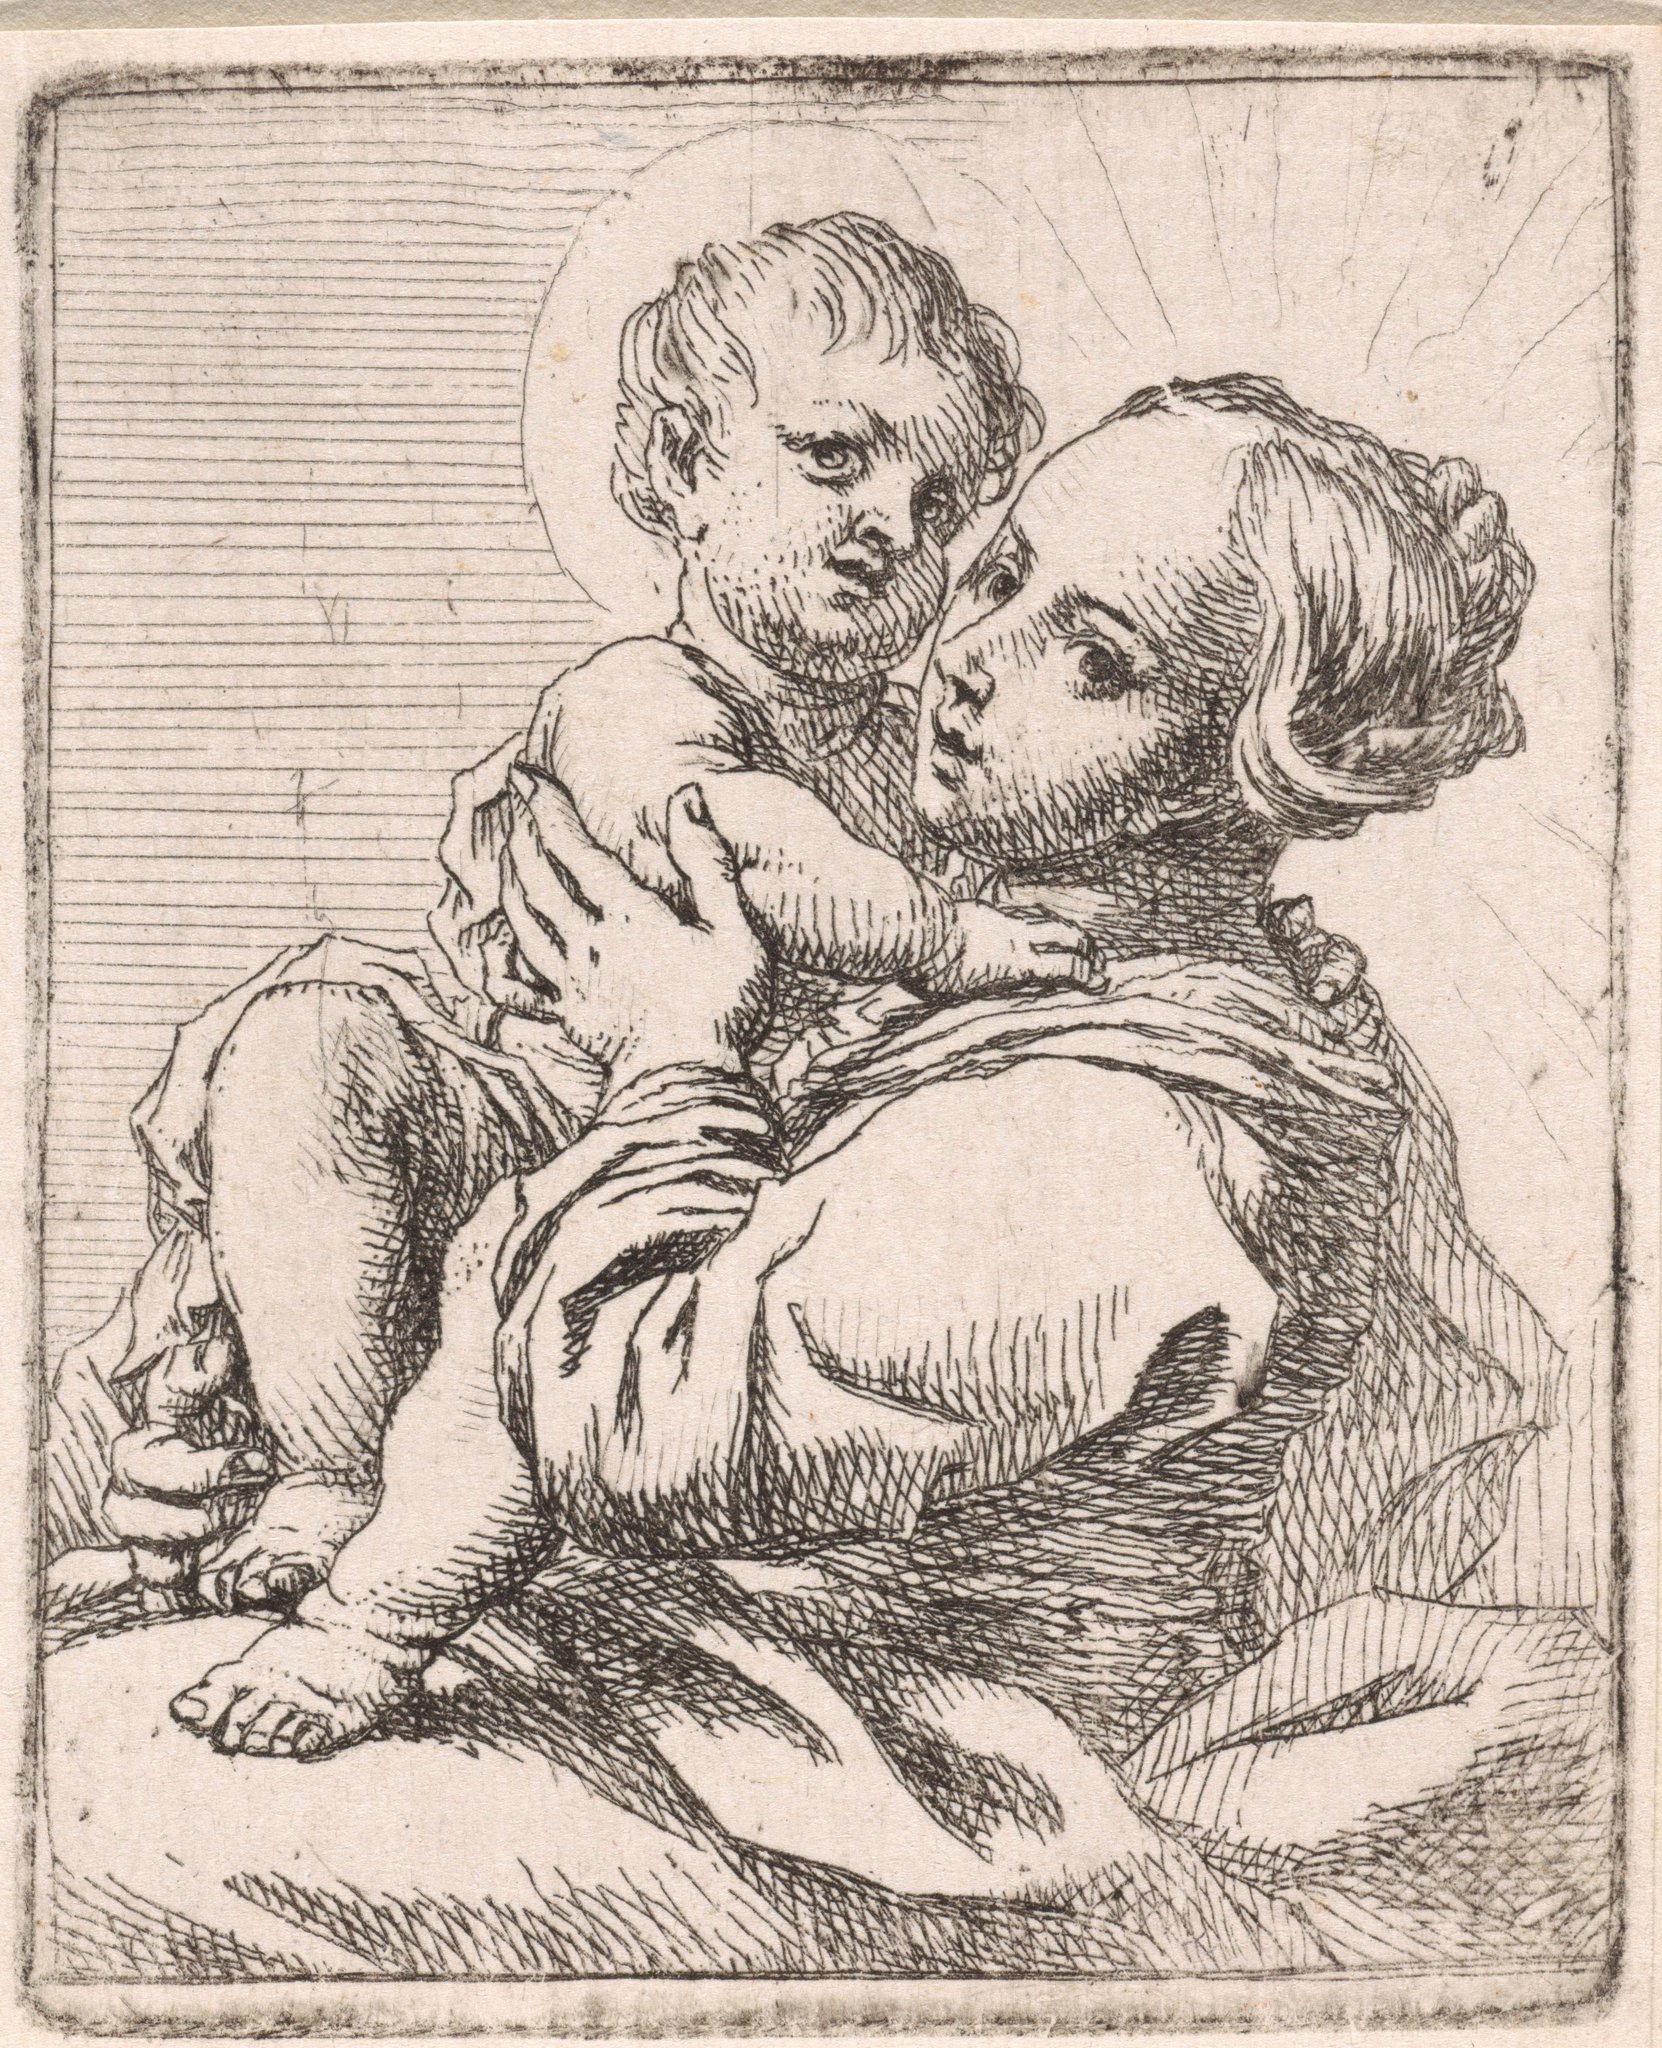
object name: print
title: Madonna met kind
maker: cornelis schut (i)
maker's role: draughtsman, print maker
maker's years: 1597-1655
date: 1618-1655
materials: paper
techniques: etching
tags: madonna: mary sitting or enthroned, the christ-child in her lap (or in front of her bosom) (mary sometimes represented half-length)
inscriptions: collector's mark: Lugt 240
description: Maria draagt het Christuskind hoog op haar rechterarm: zijn voeten rusten op haar schoot.